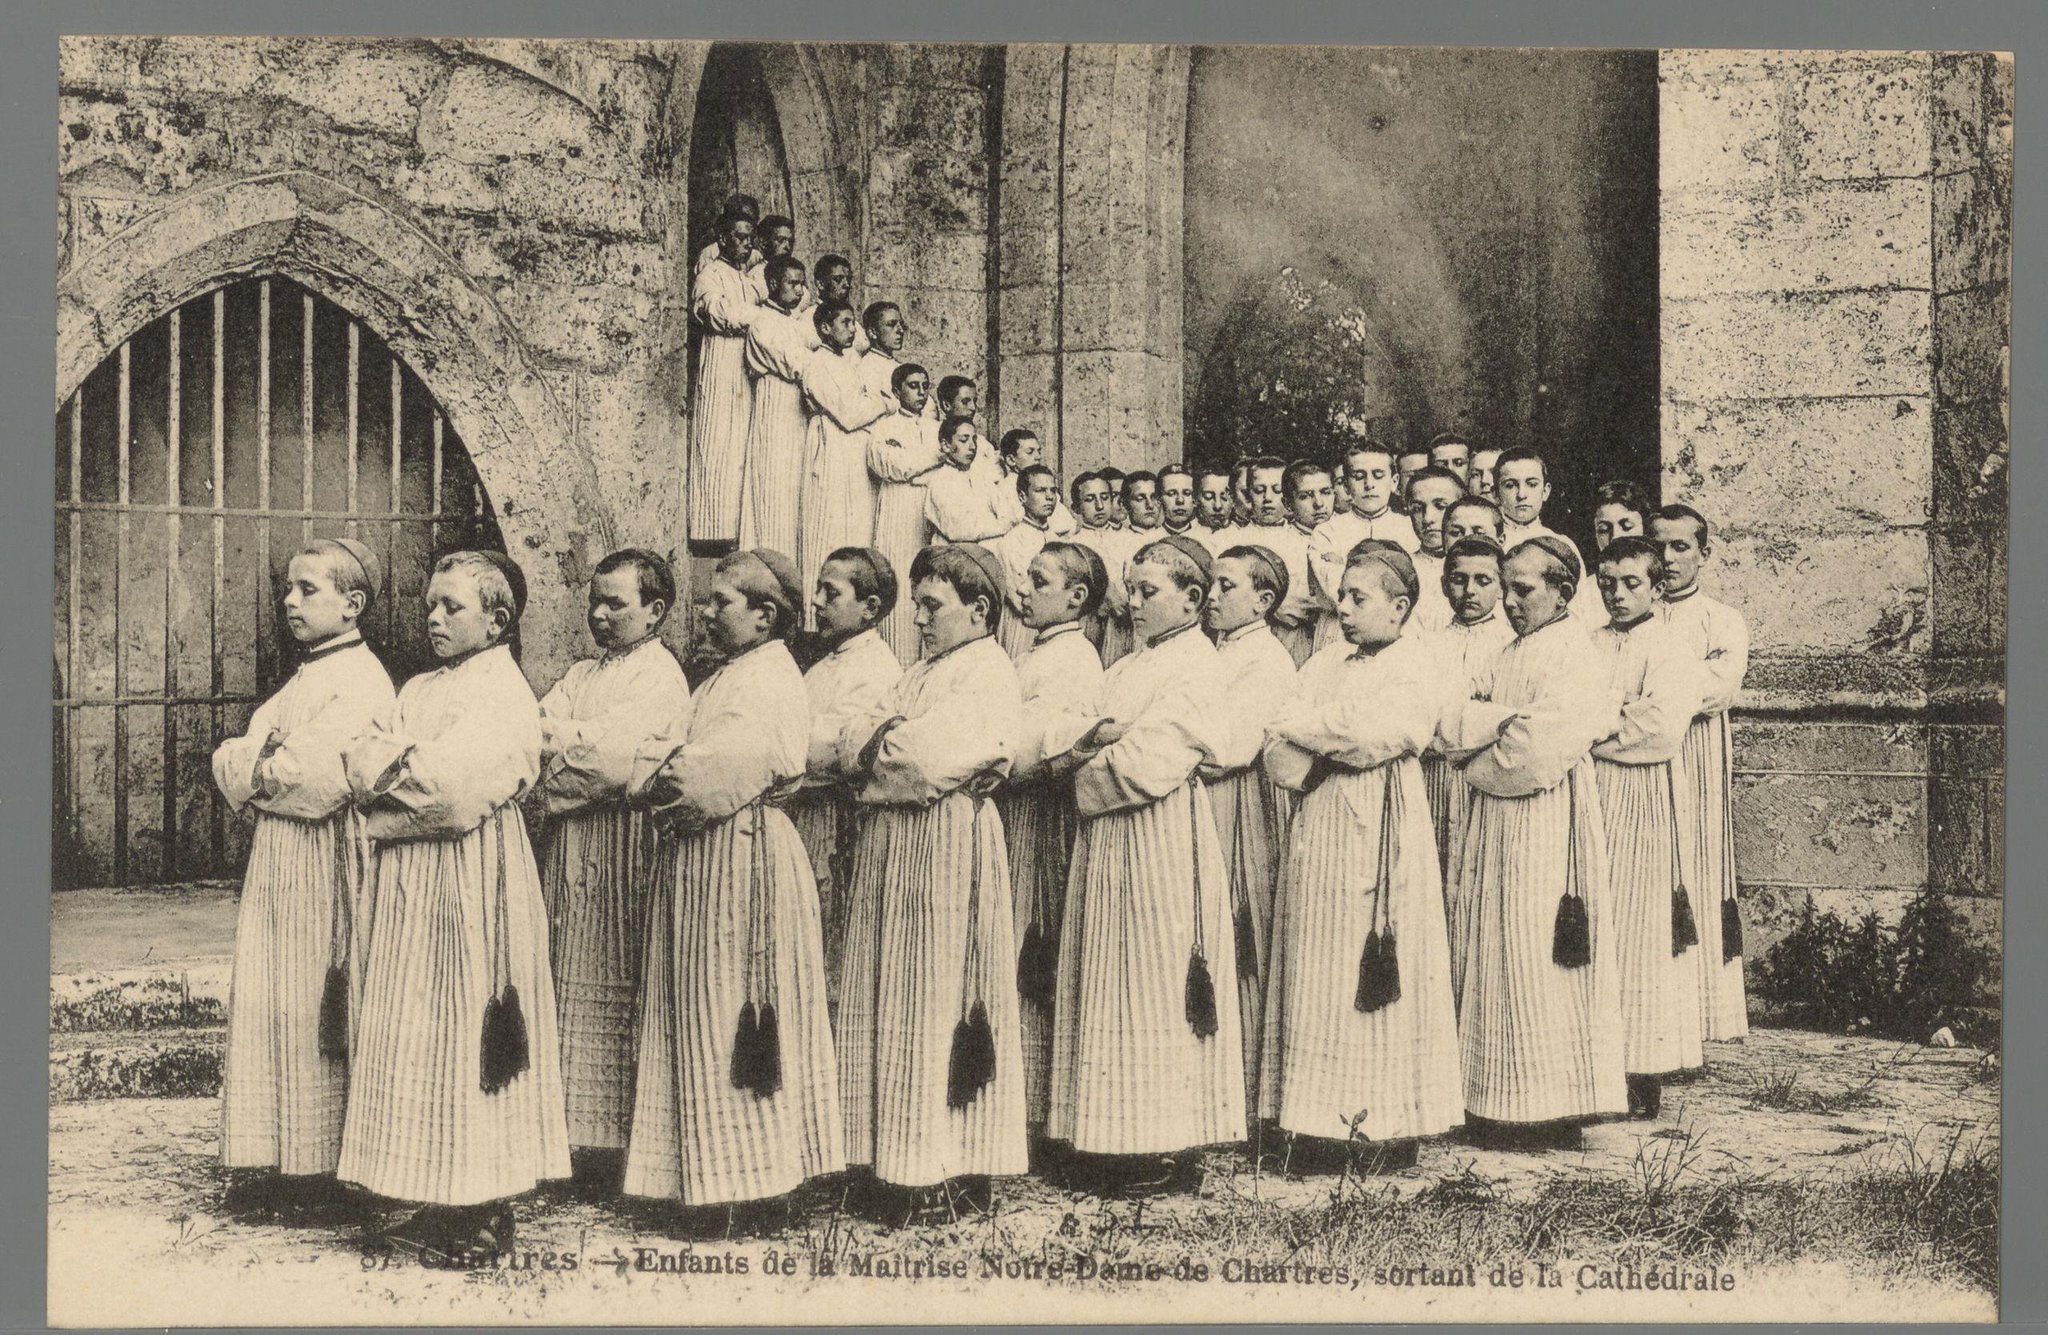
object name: photomechanical print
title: Chartres. Enfants de la Maîtrise Notre-Dame de Chartres, sortant de la Cathédrale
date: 1903-1930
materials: cardboard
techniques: photograph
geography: chartres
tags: leaving the church after service, church (exterior)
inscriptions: collector's mark: ‘AFE v S’